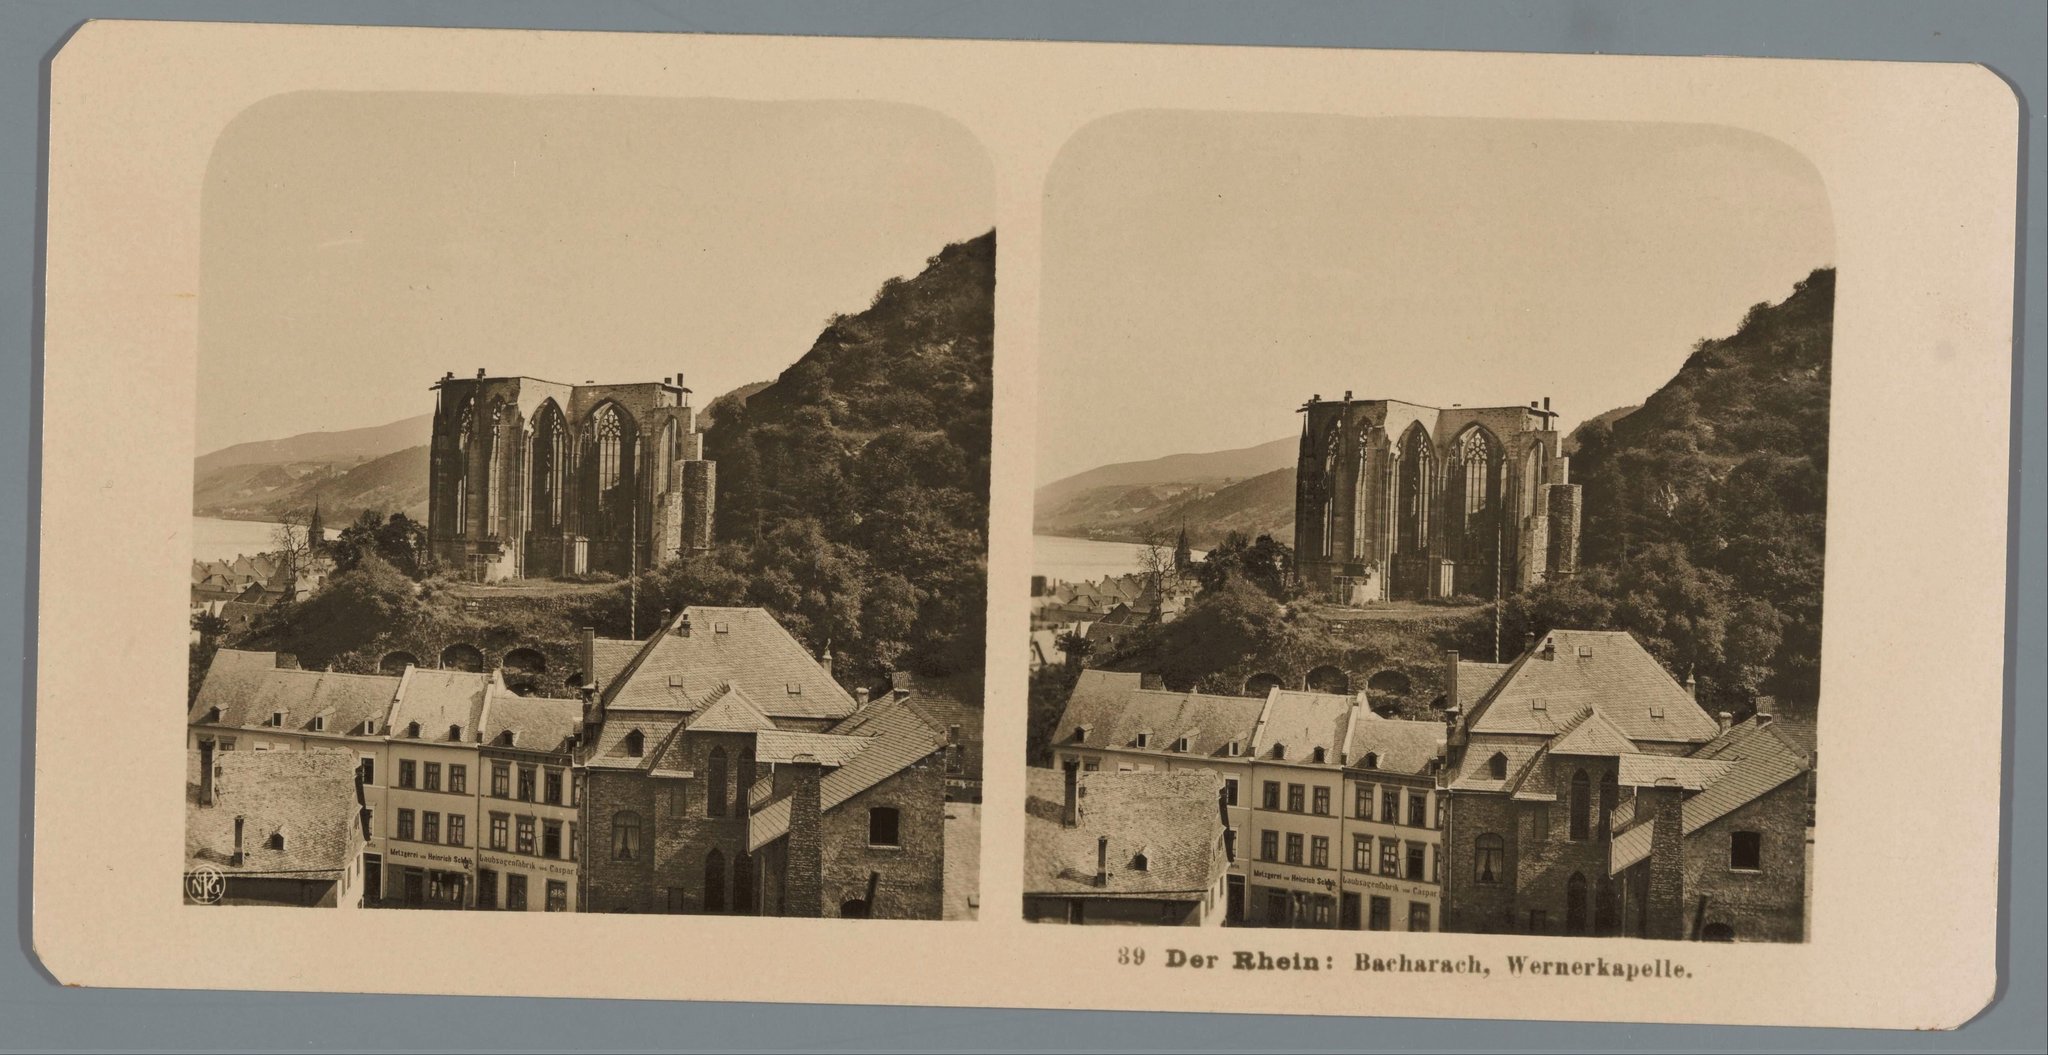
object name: stereograph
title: Gezicht op de ruïne van de Wernerkapel te Bacharach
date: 1900-1910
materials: cardboard, photographic support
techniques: gelatin silver print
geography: bacharach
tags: ruin of church, monastery, etc.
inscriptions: inscription: ‘NPG’, number: ‘39’